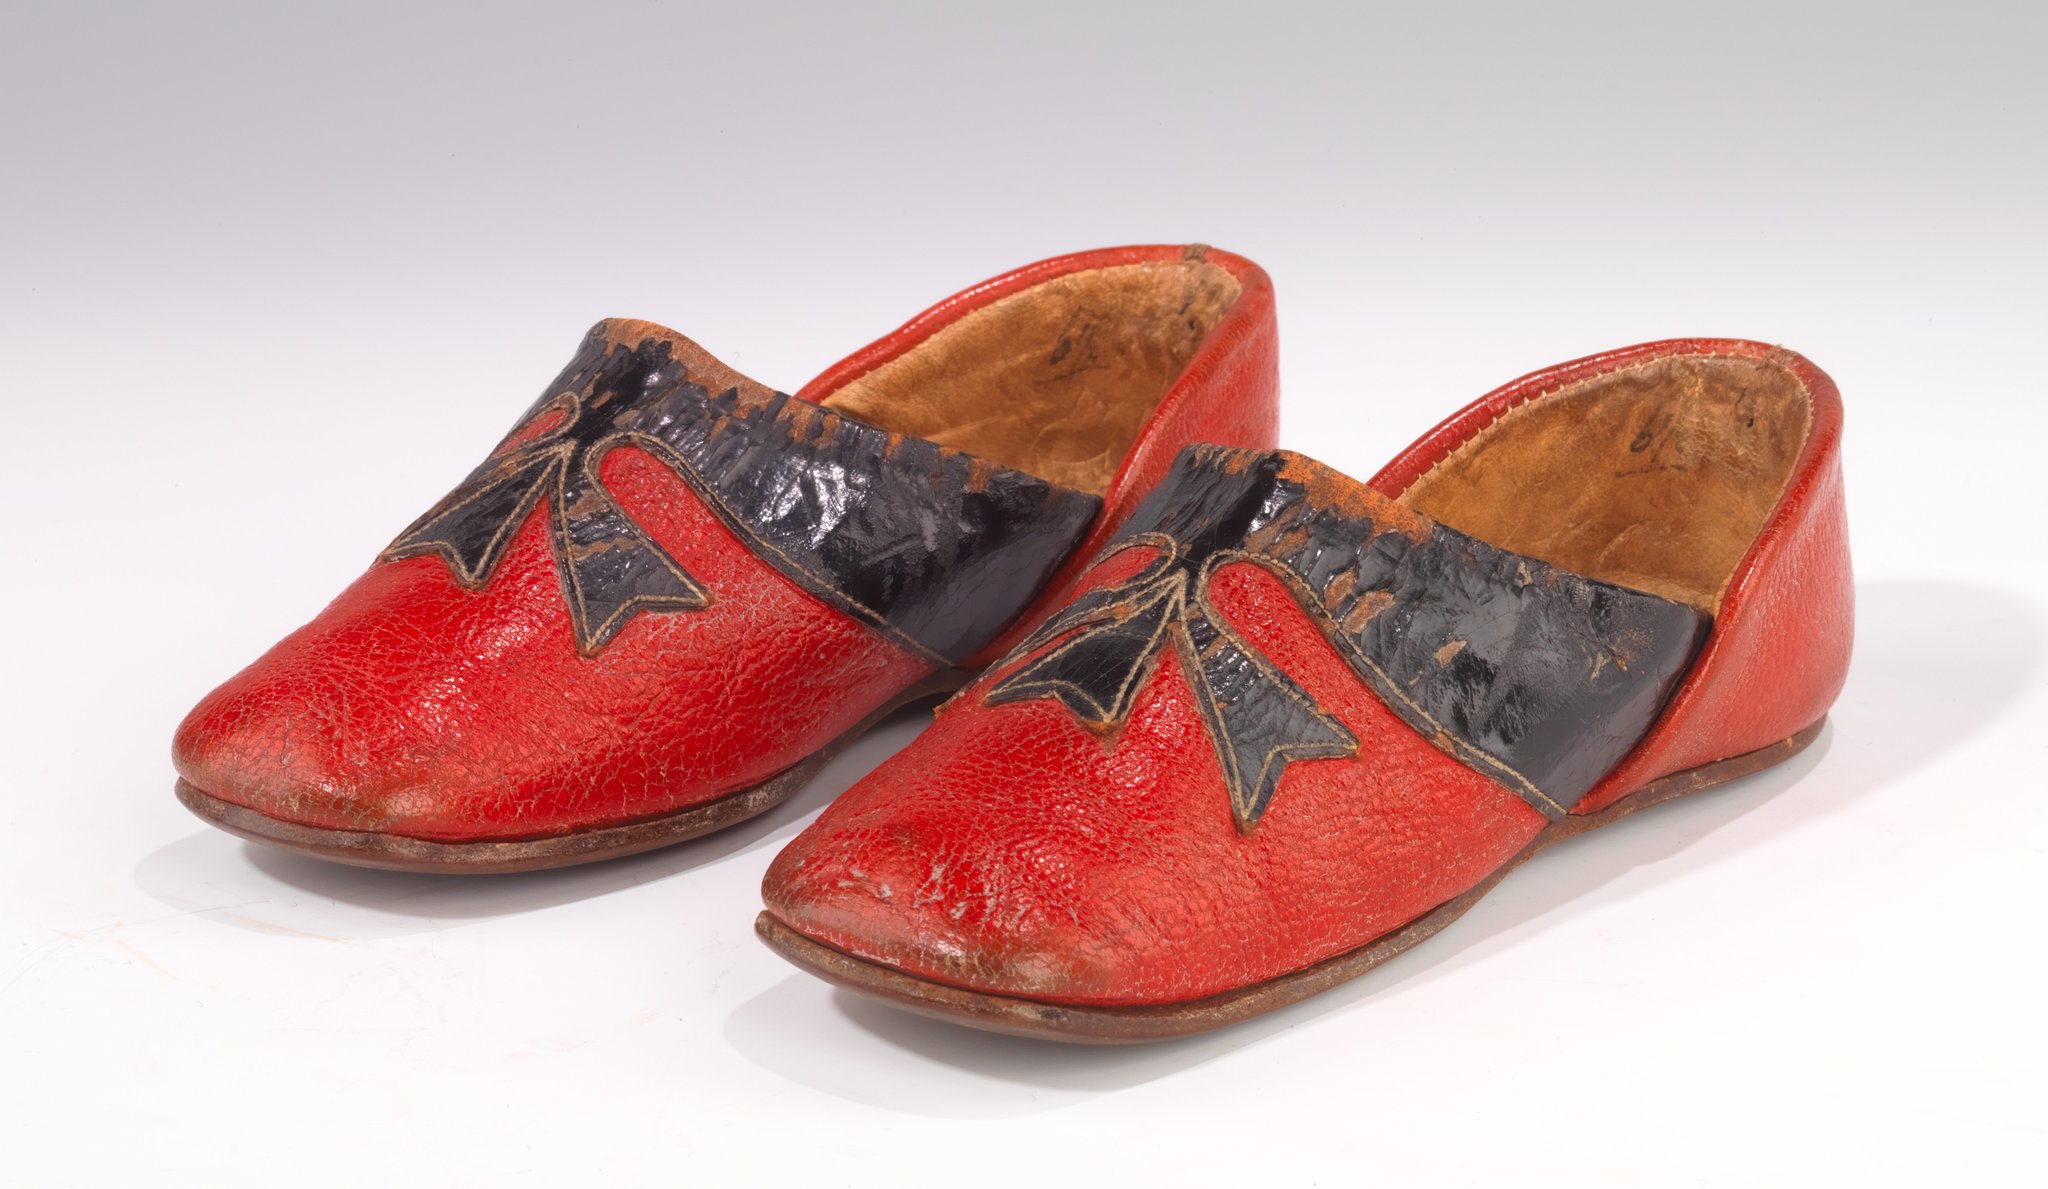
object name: slipper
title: Slippers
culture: american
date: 1850-1875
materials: leather